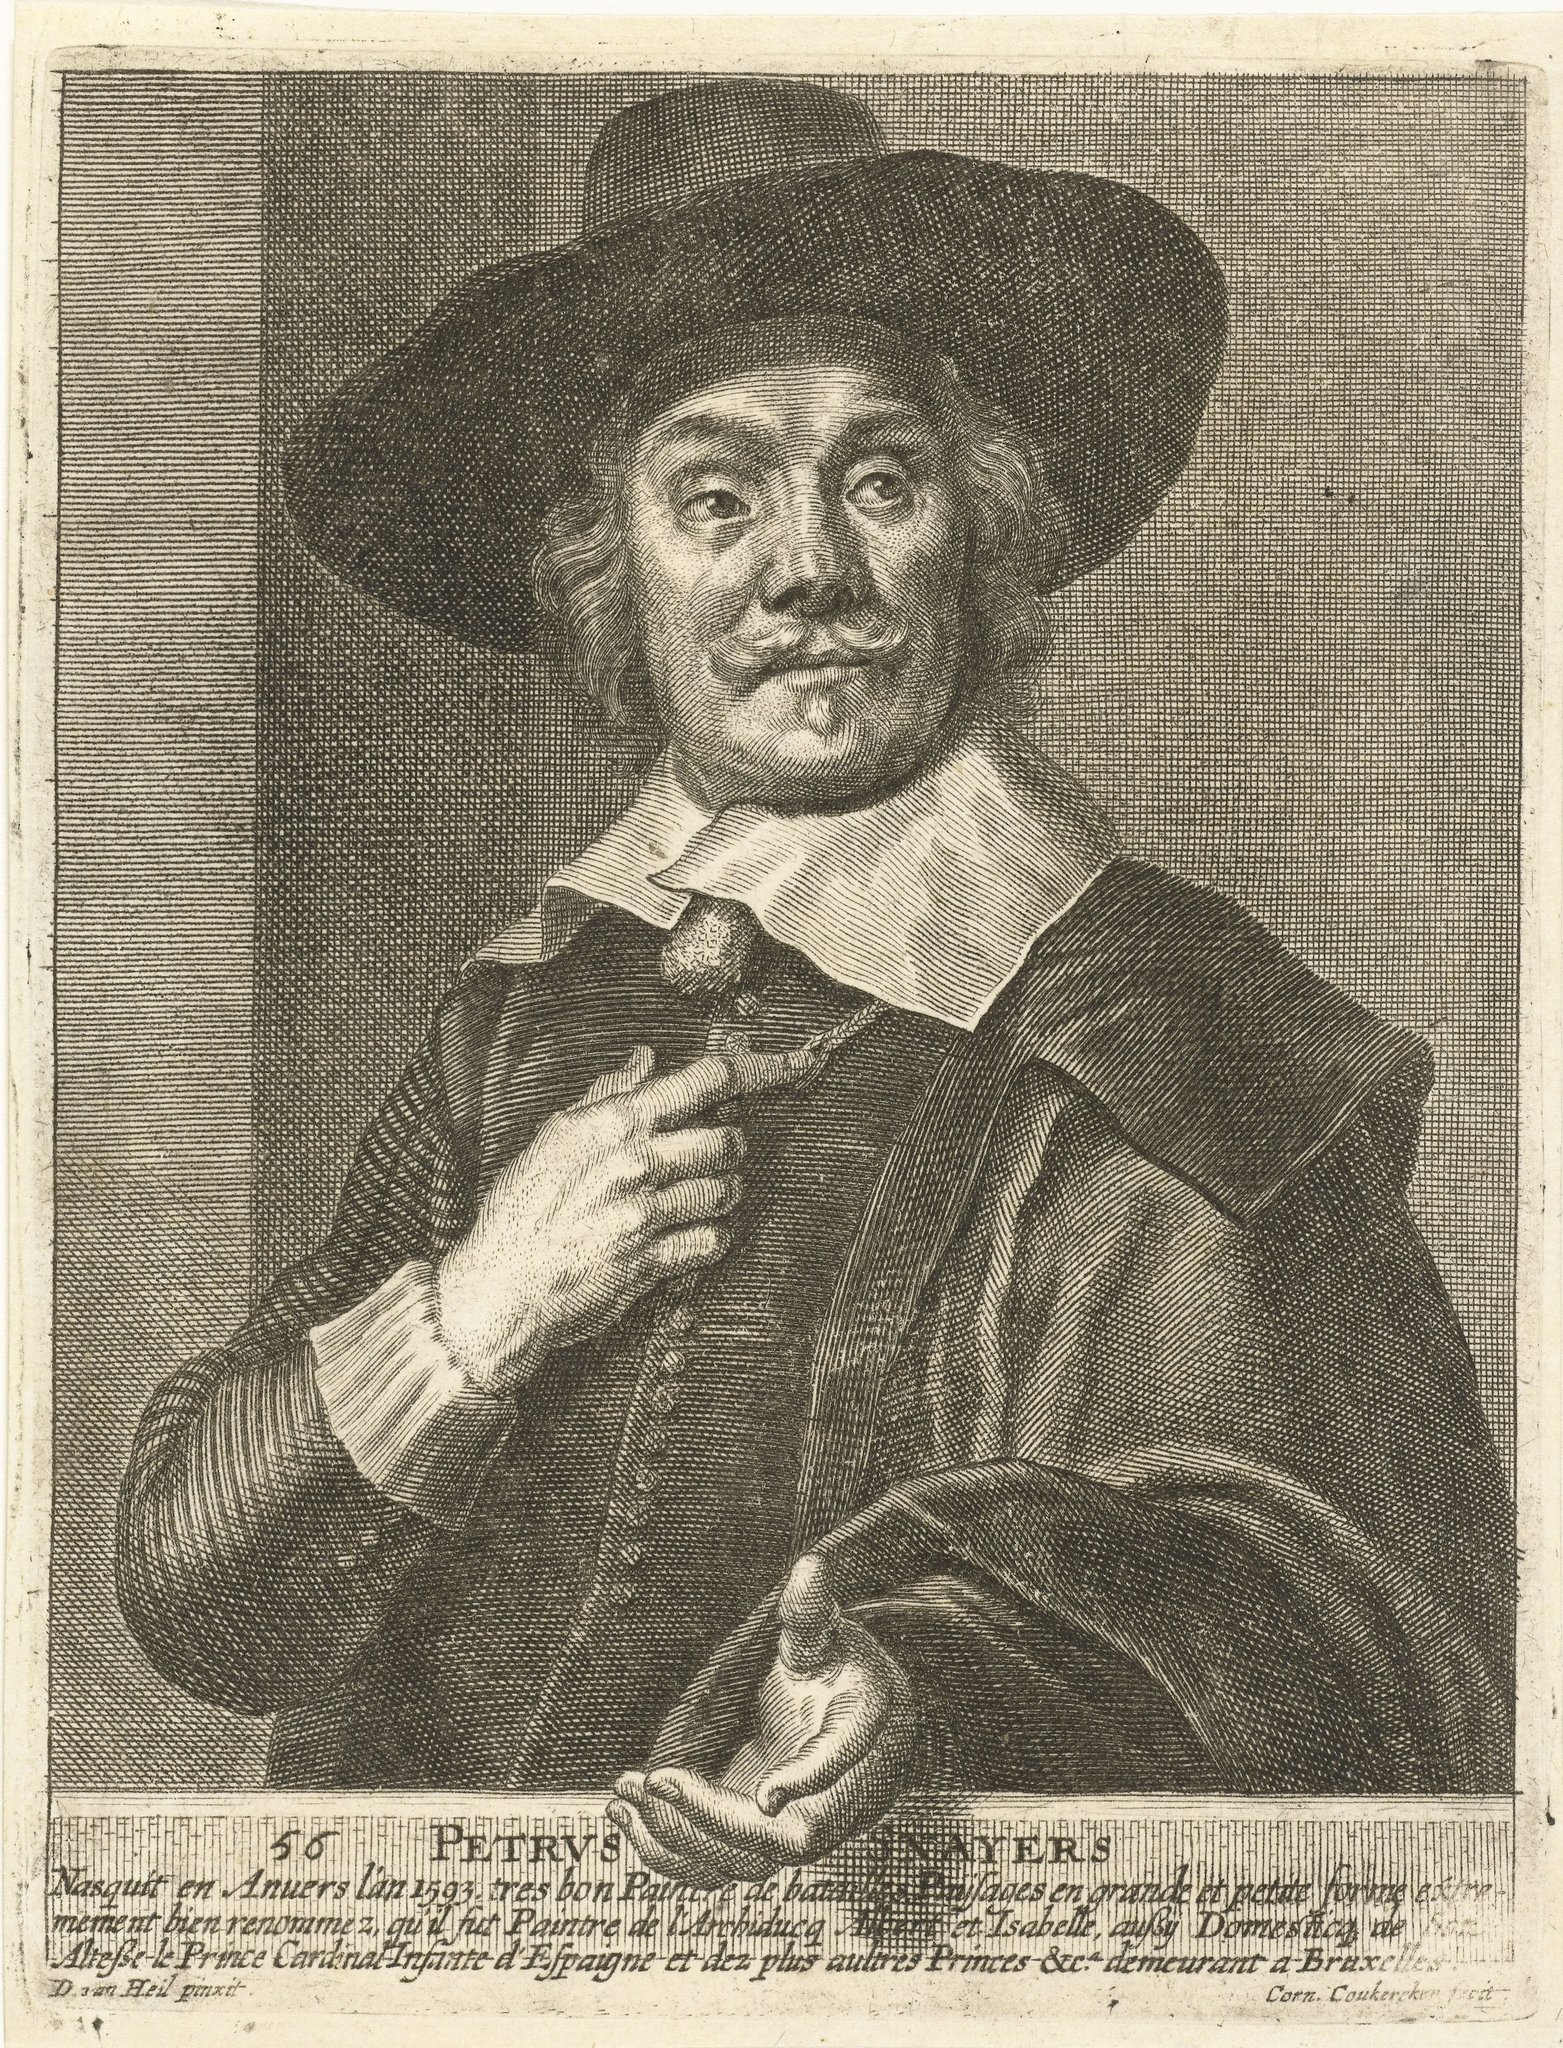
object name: print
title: Portret van de schilder Petrus Snayers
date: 1649-1662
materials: paper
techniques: engraving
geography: southern netherlands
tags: antwerp, brussels, draughtsman, peeter snayers, painter in non-work situation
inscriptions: collector's mark: Lugt 2228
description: Prent gebruikt in: Resta, Sebastiano. The true effigies of the most eminent painters and other famous artists that have flourished in Europe. Londen, 1694.